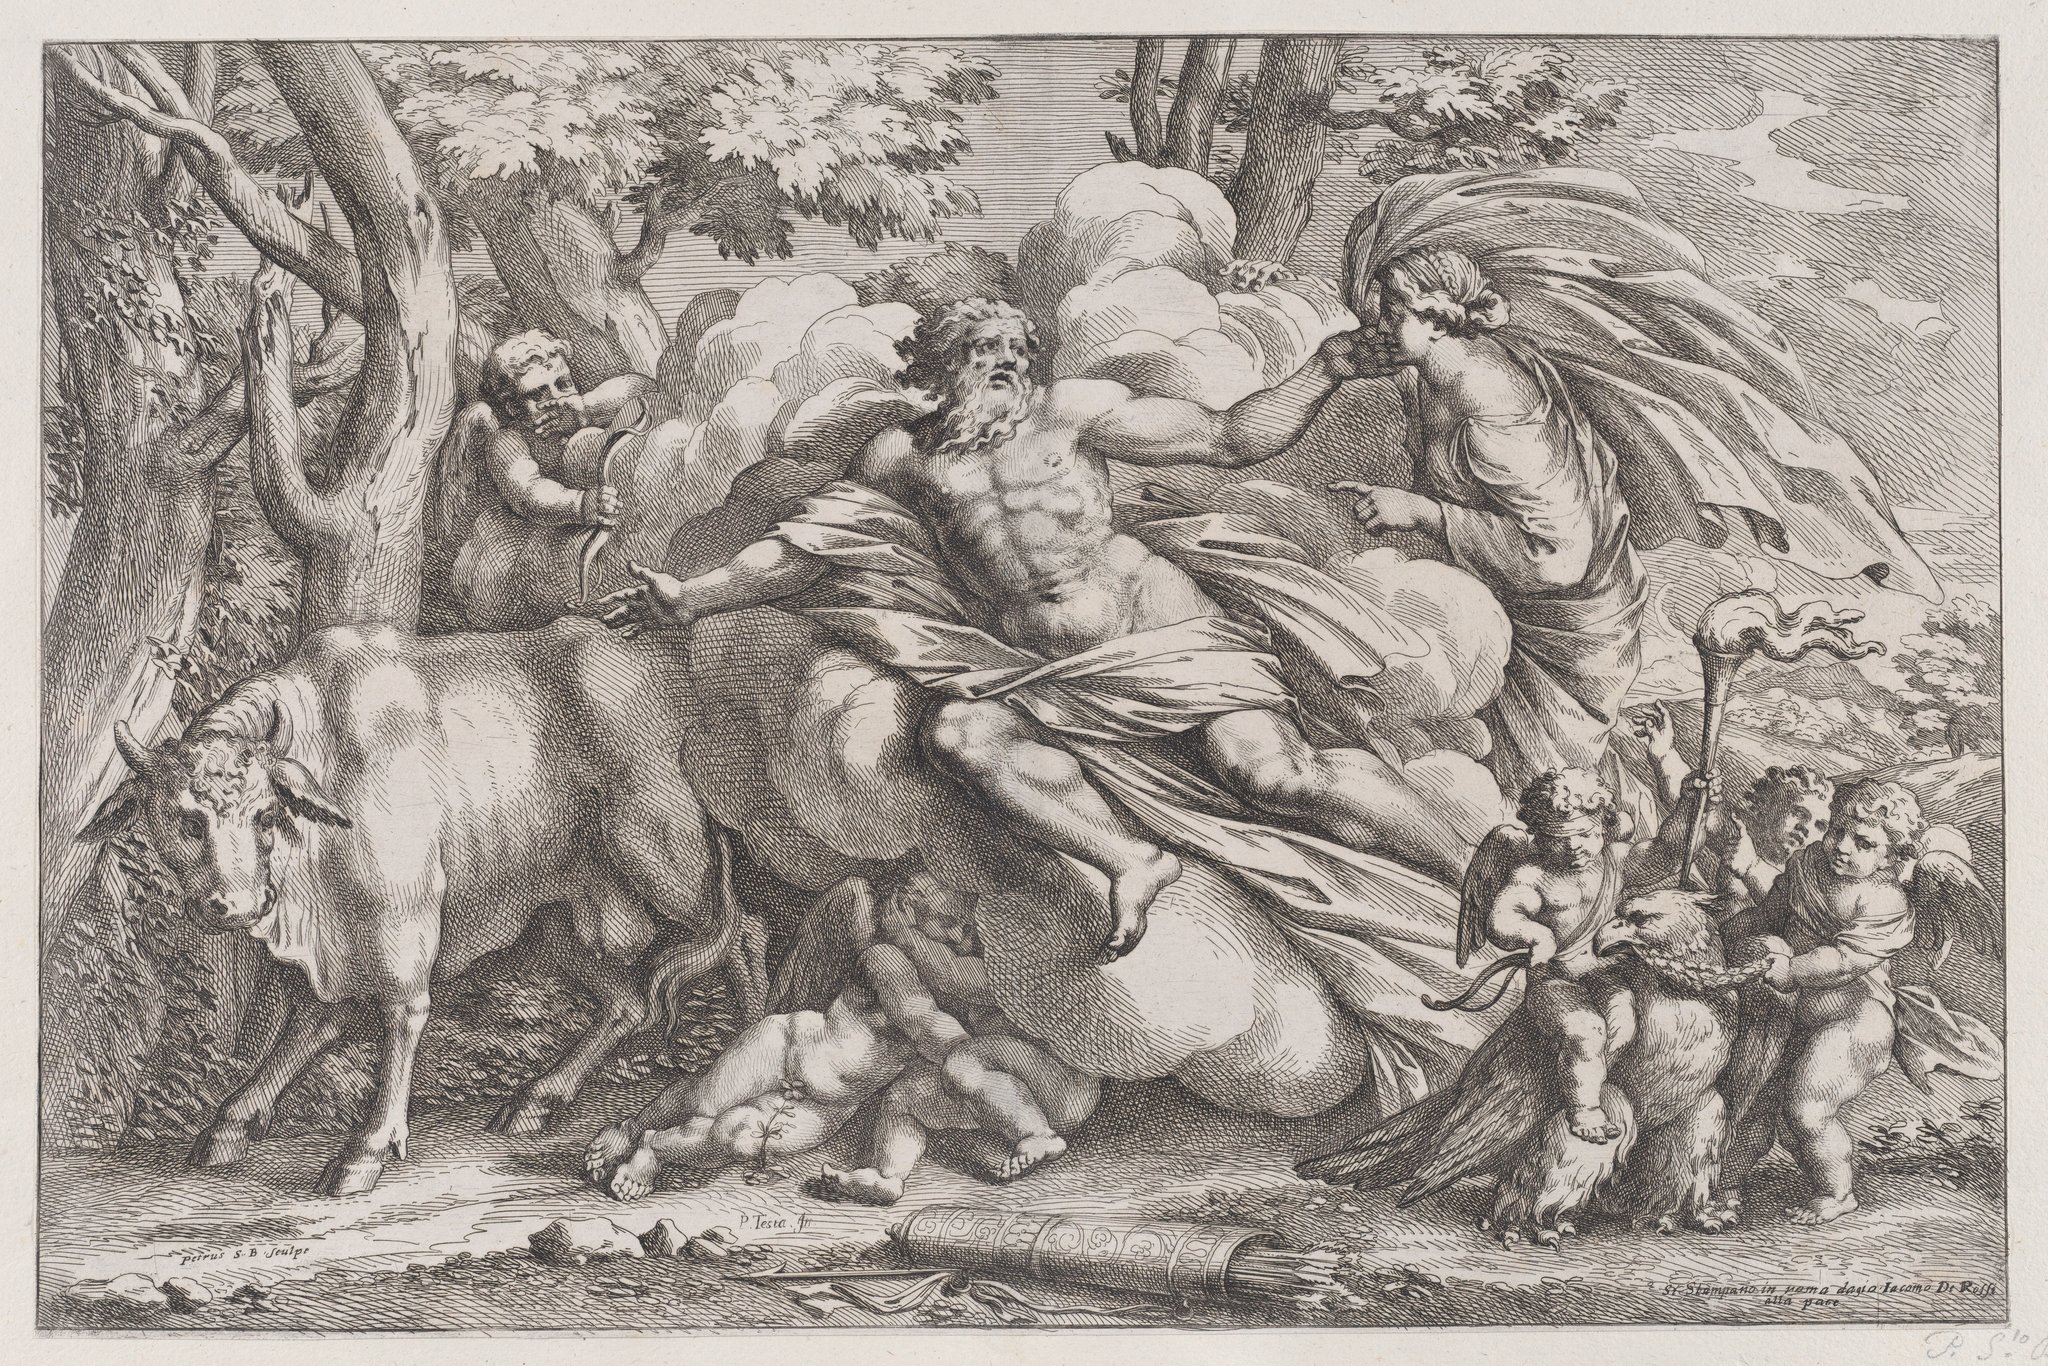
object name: print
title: Io at the left as a cow, Jupiter on a cloud in the centre and Juno at the right with putti holding an eagle captive in the lower right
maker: pietro santi bartoli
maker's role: artist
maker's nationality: italian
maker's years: 1615-1700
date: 1650-1690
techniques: etching